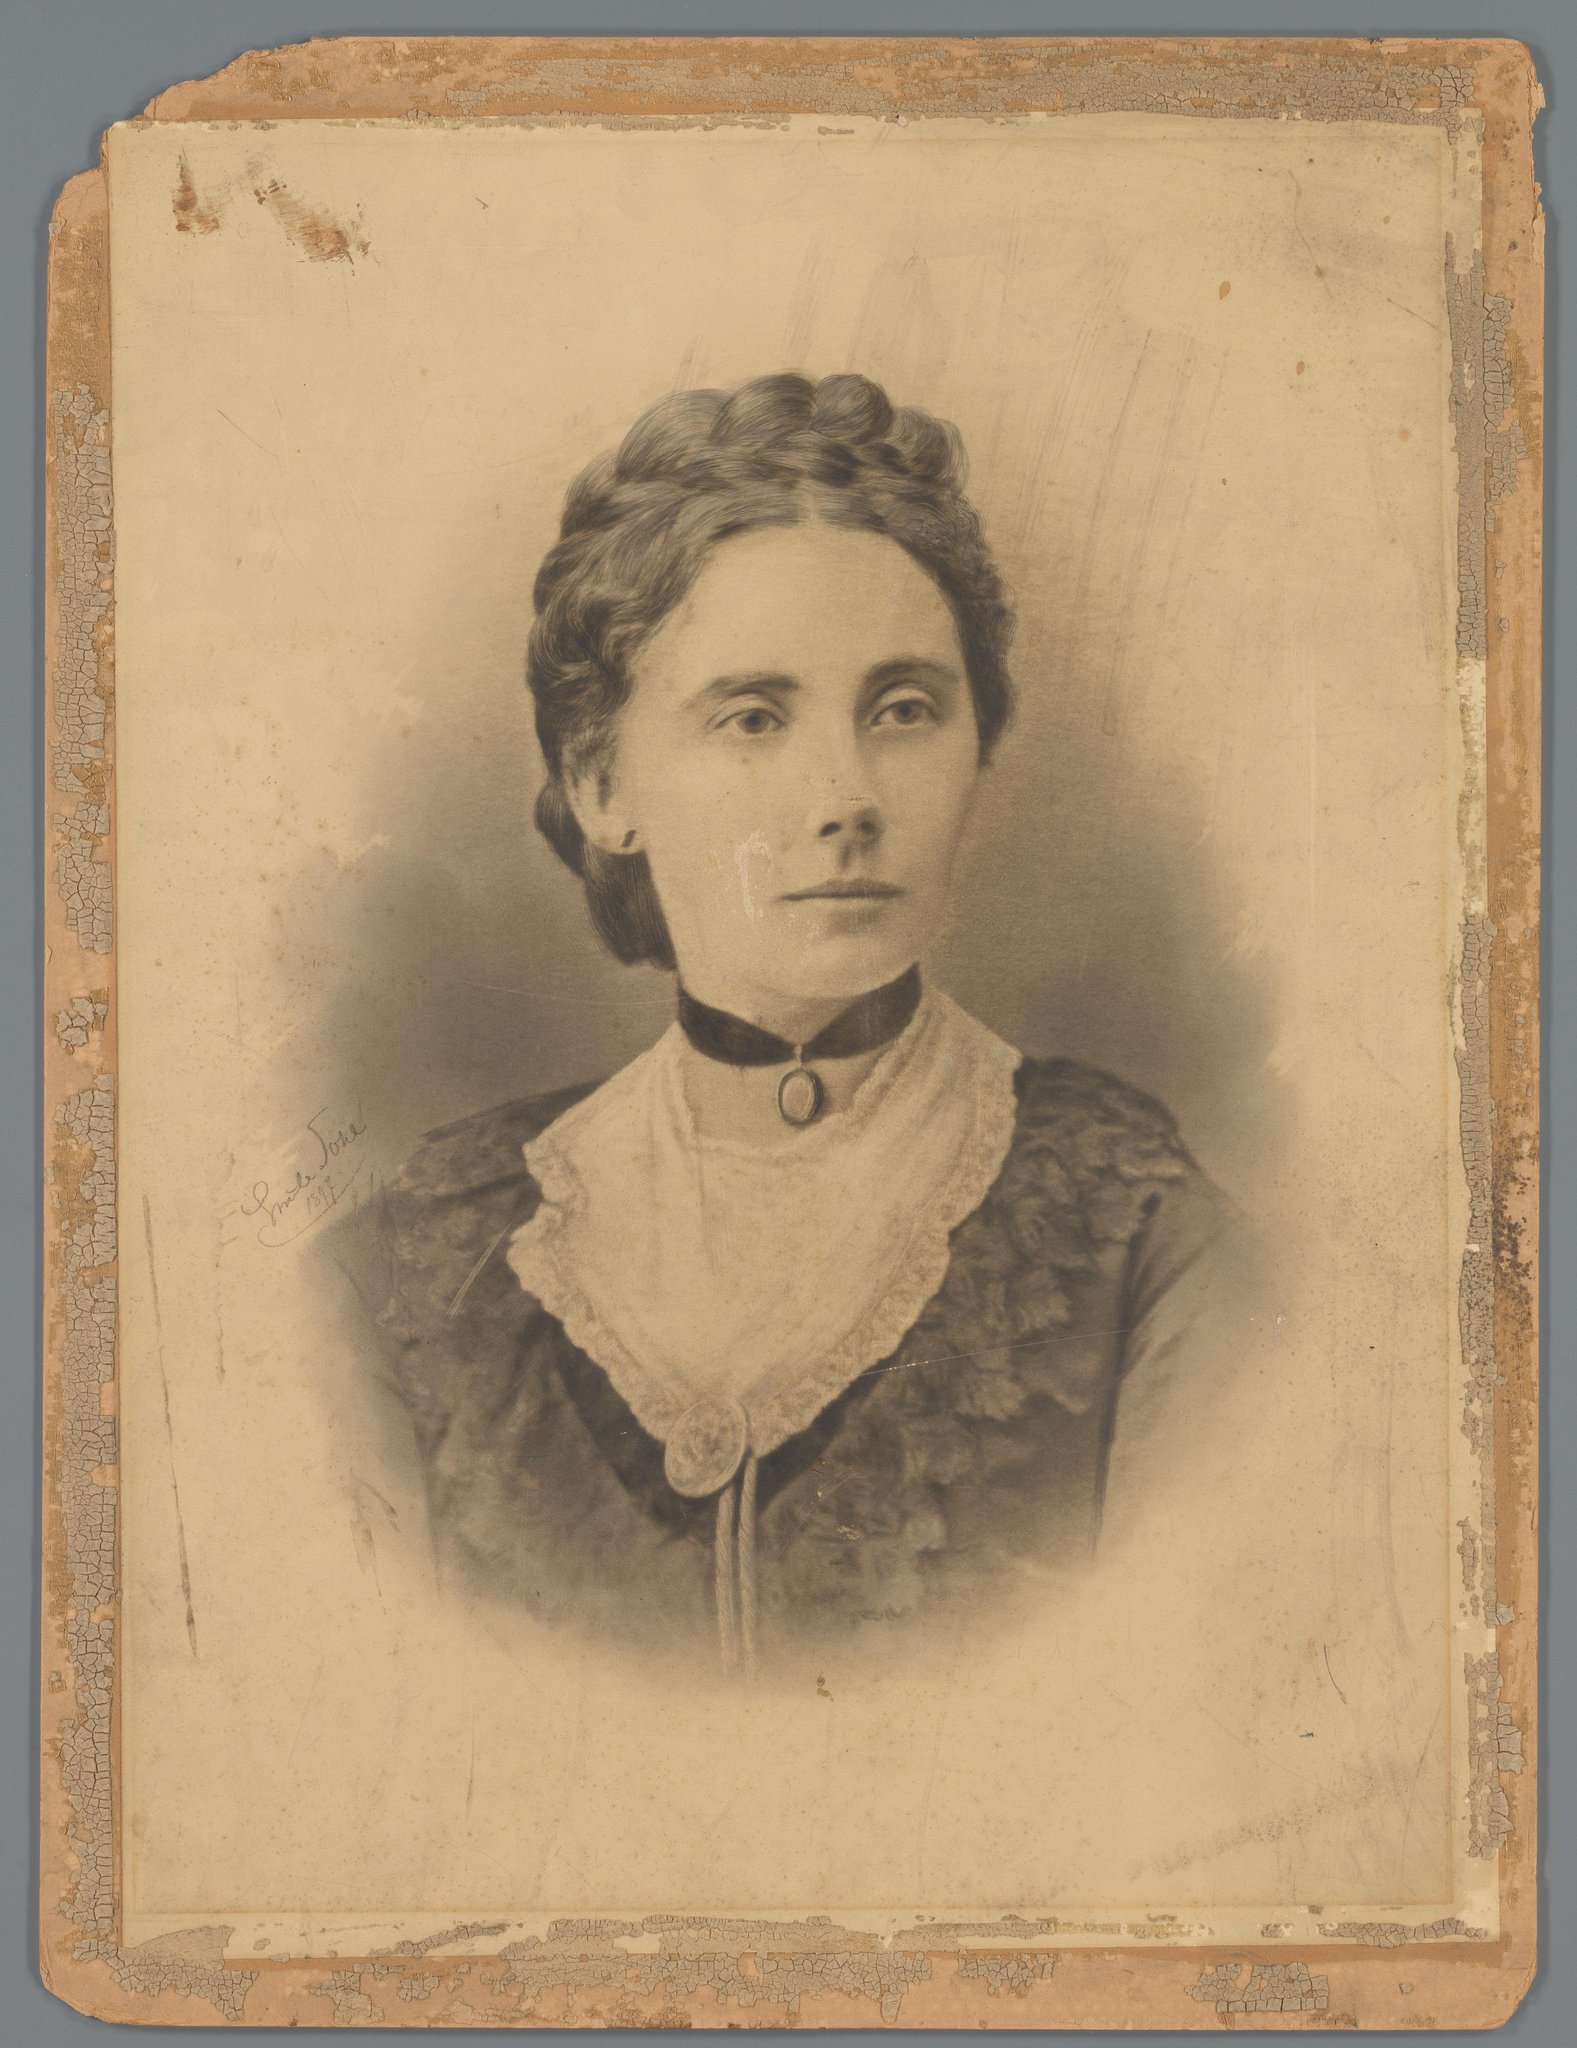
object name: crayon enlargement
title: Portret van een onbekende vrouw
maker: emile sohl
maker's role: fotograaf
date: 1897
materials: paper, cardboard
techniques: gelatin silver print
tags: anonymous historical person portrayed alone - bb - woman